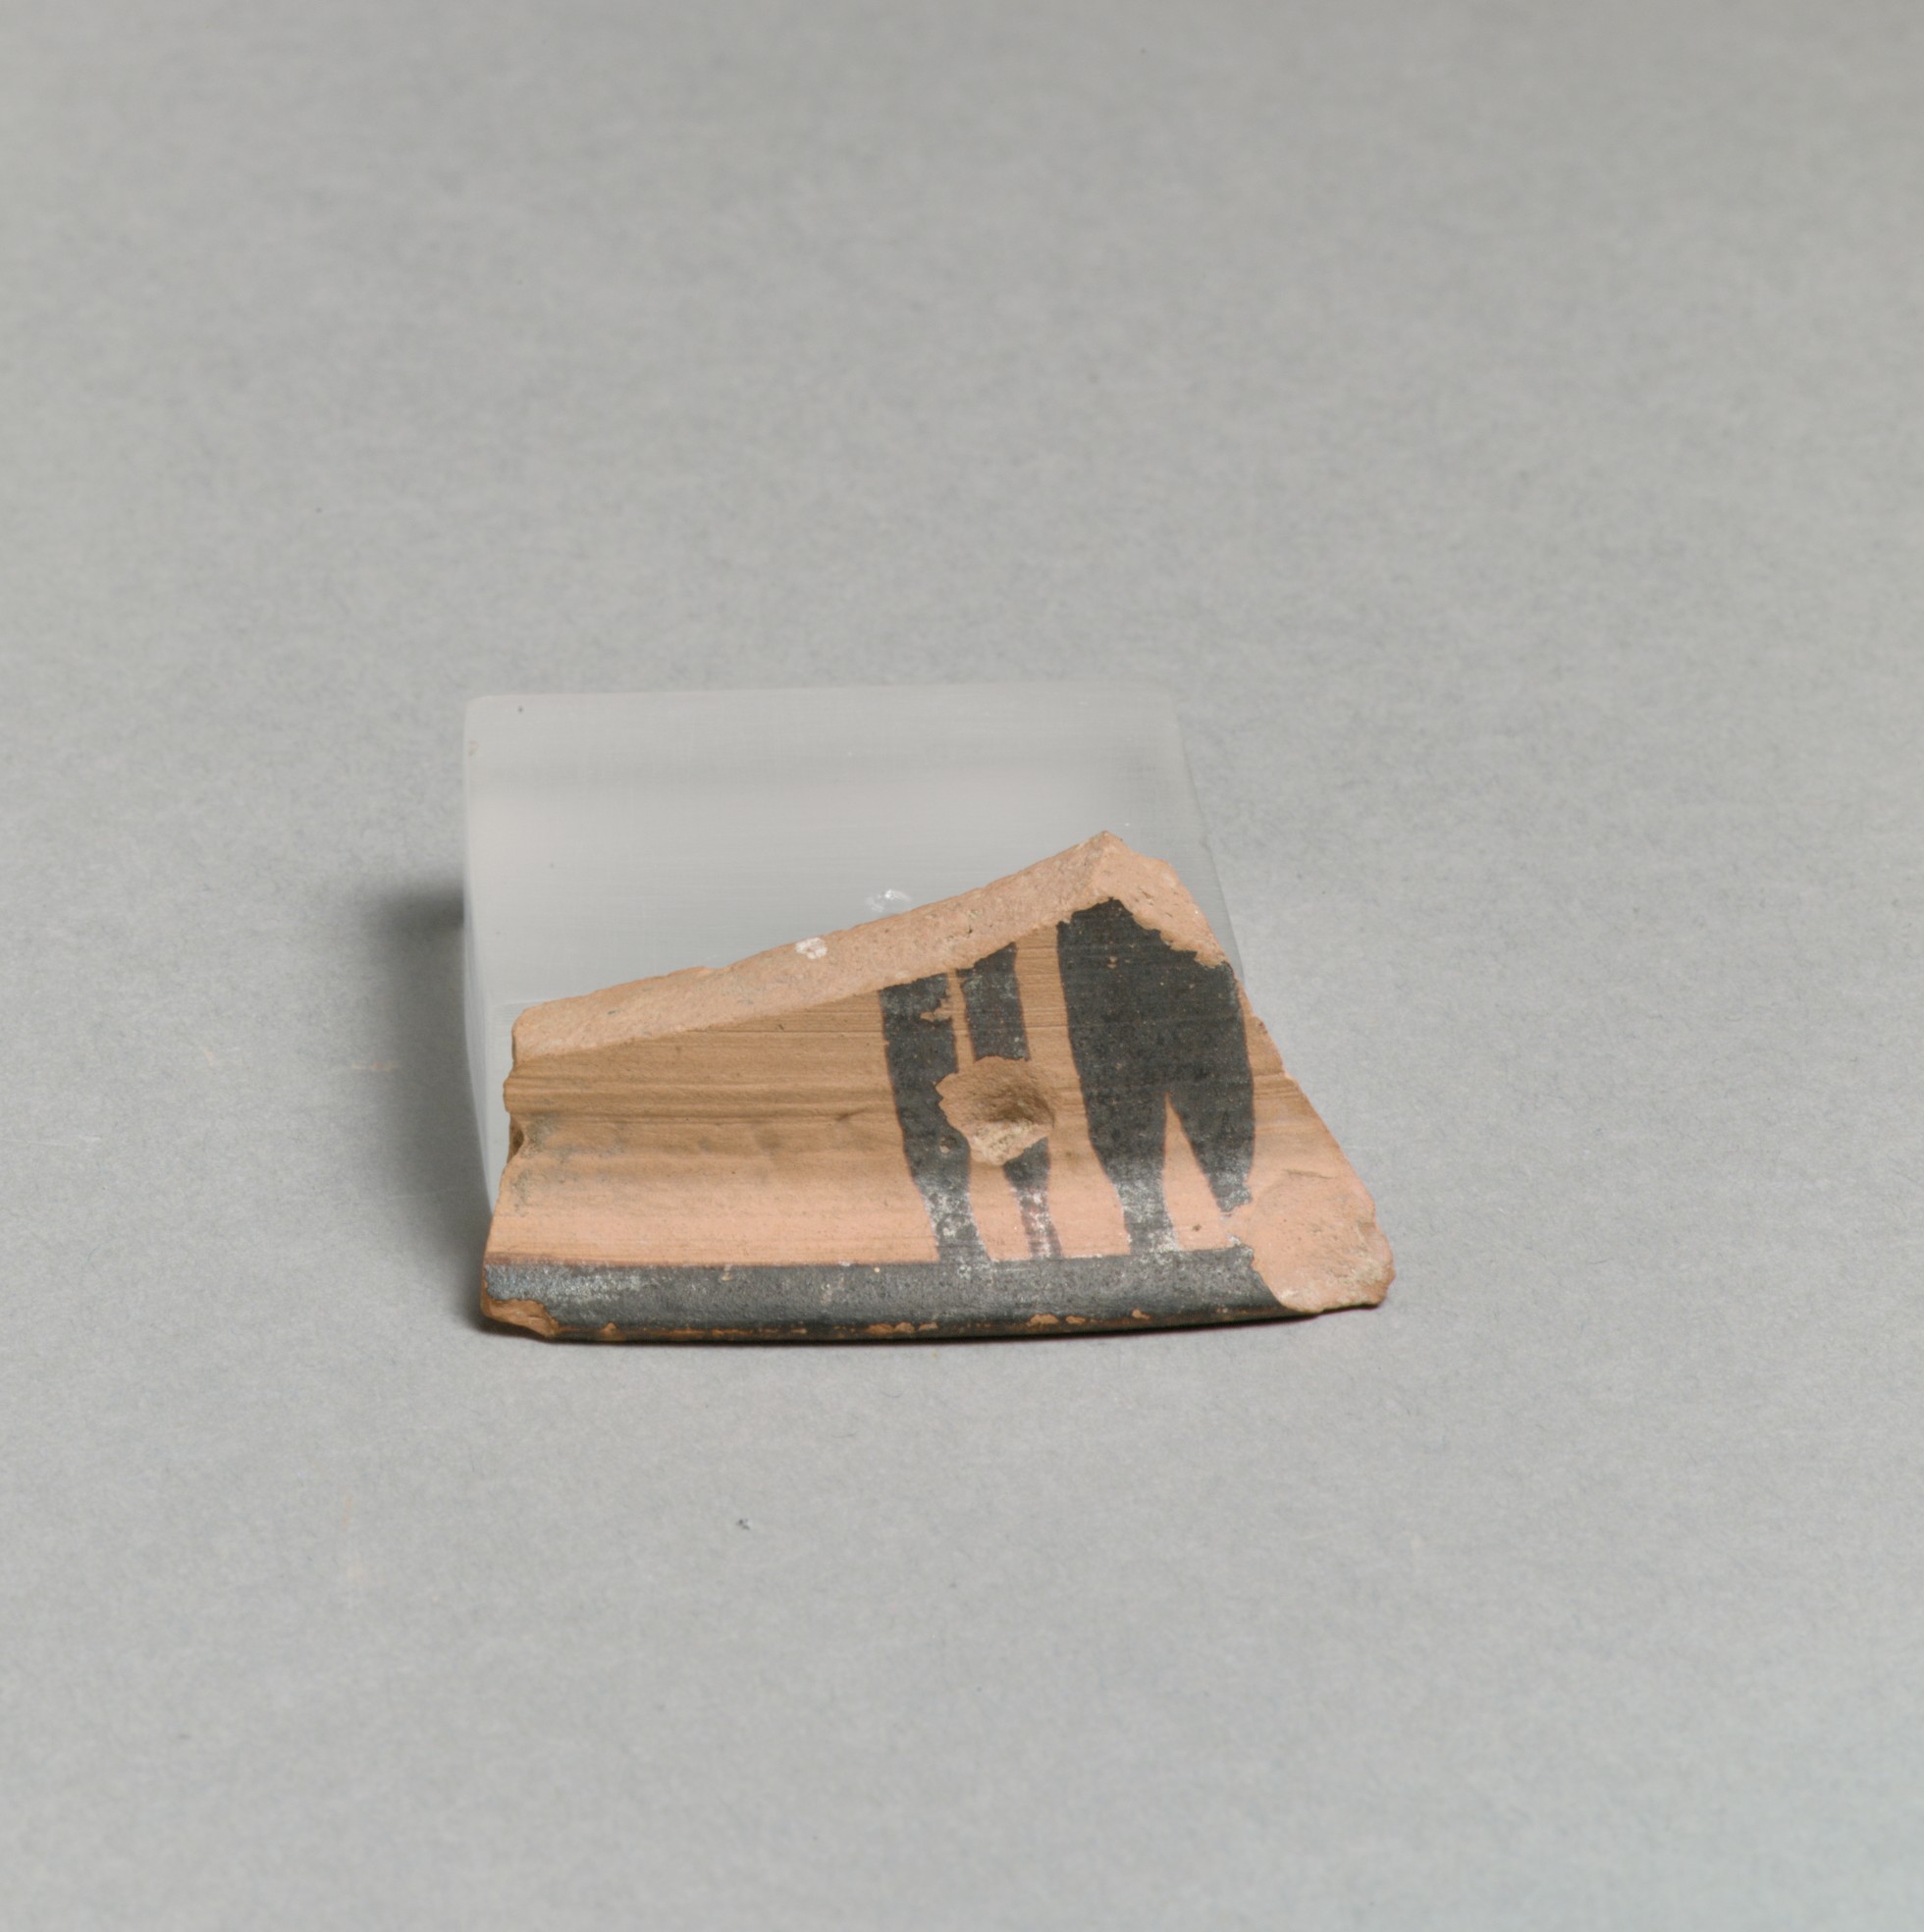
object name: vase fragment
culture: greek, laconian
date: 2000-1550 BCE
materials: terracotta